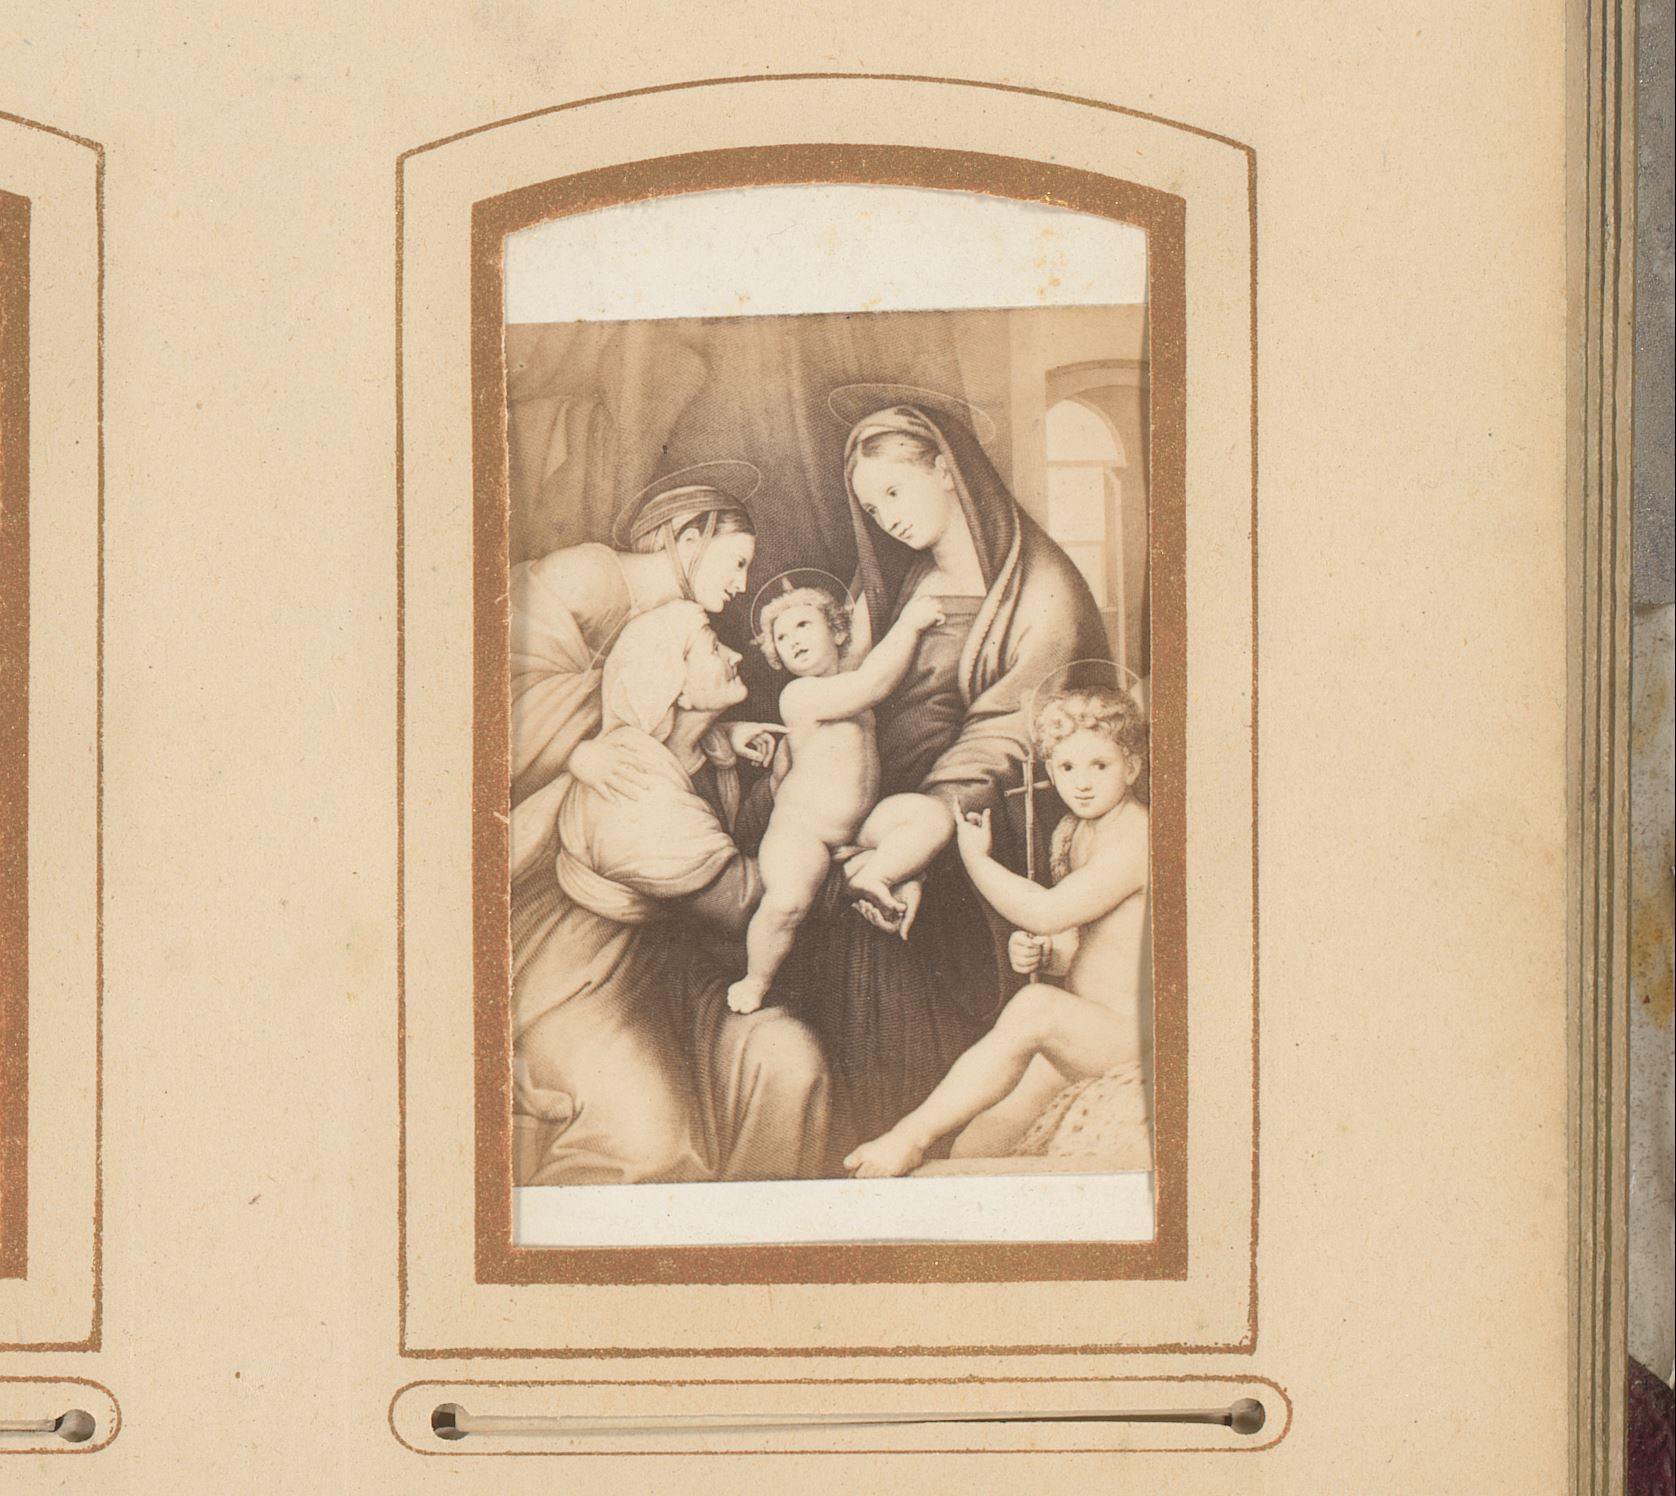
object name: photograph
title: Fotoreproductie van Madonna dell'Impannata door Rafaël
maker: rafaël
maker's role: painter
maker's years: 1483-1520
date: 1850-1900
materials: cardboard, photographic support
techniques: albumen print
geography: florence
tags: mary, the christ-child and john the baptist, elisabeth present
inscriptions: inscription: ‘FRATELLI ALINARI/ FIRENZE/ Piazza S. Gaetano’, annotation: ‘10[9]/ Madonna del Impa/ nata Raffaella/ Firenz’